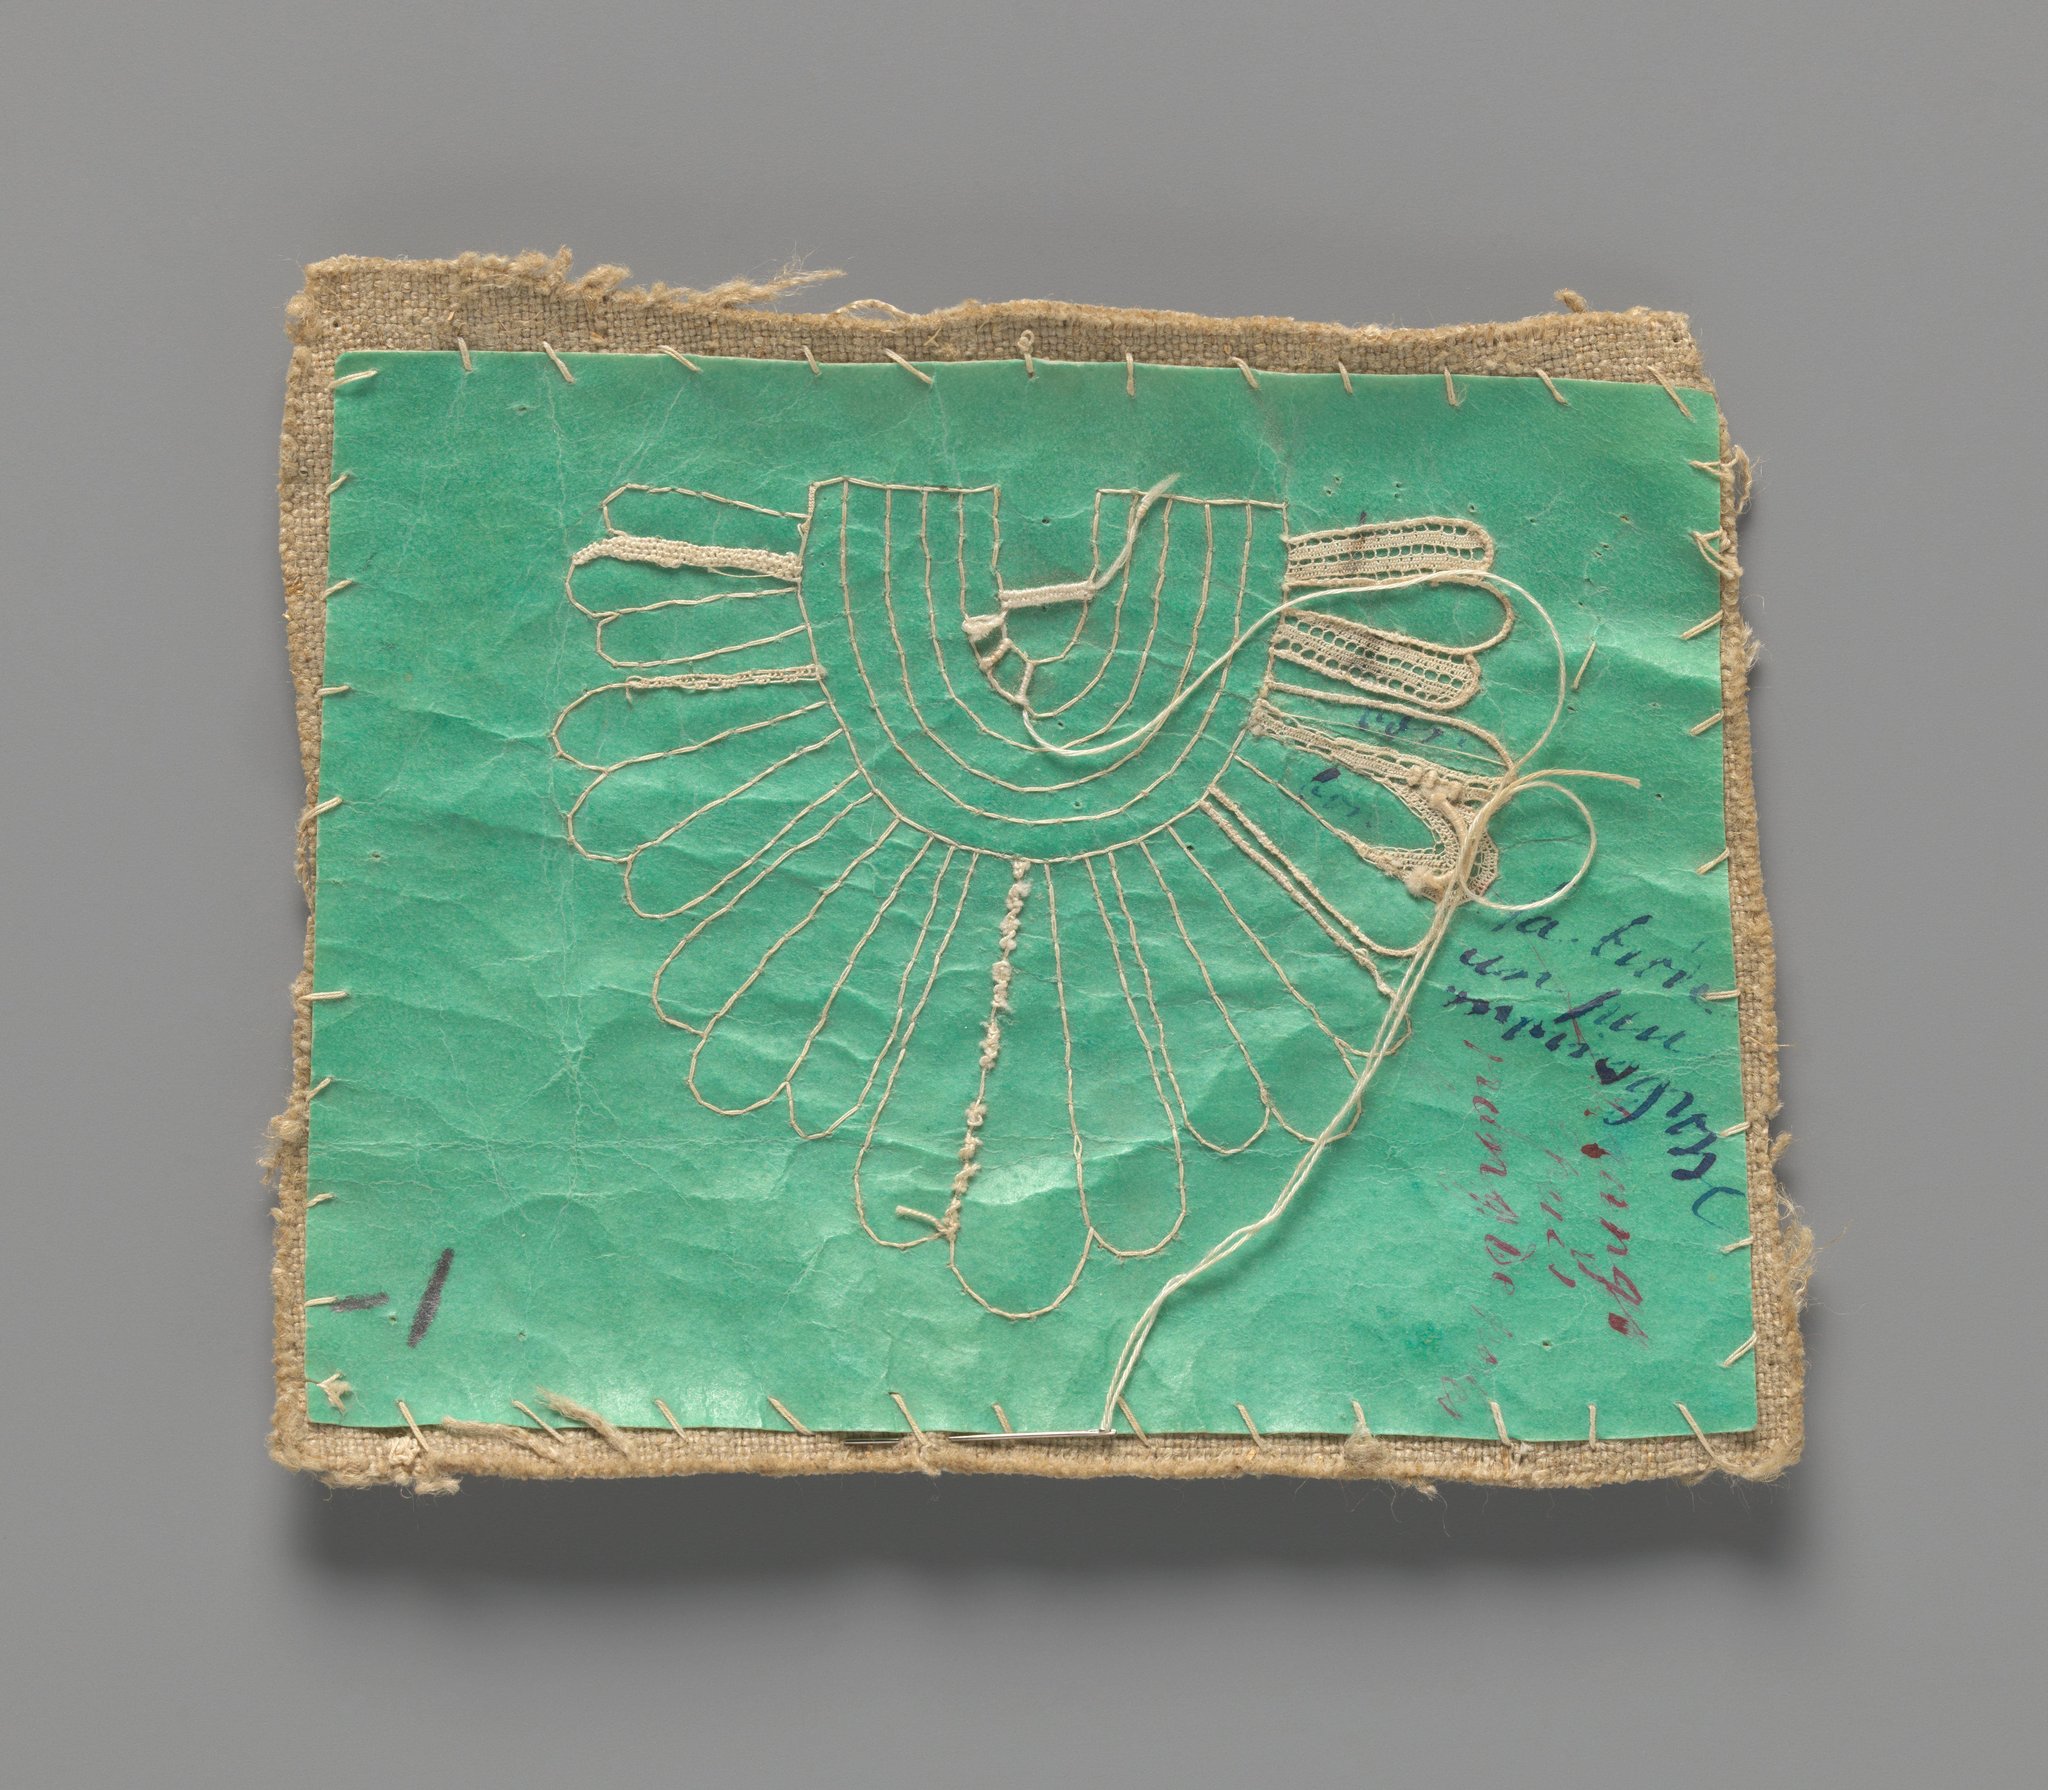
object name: tool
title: Gereedschap voor een naaldkantmotief in de vorm van kleermakerslinnen waarop groen perkament is genaaid met witte traceerdraden in een halve waaiervormige bloem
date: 1906-1910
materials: linen, parchment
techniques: sewing, weave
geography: the hague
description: Gereedschap voor een naaldkantmotief in de vorm van dubbel kleermakerslinnen waarop groen perkament is genaaid. Op het perkament is met witte traceerdraden een waaiervorm gemaakt met in het centrum een regenboog met daar omheen drievoudige bloembladeren, zeven in totaal naar het hoogste punt toenemend in formaat. Een deel van de traceerdraden is al bewerkt met festonsteken en er is in de bloembladeren begonnen met het maken van vullingen. Op het perkament staat geschreven met potlood: "1-" en een slecht leesbare tekst in blauwe en rode inkt.